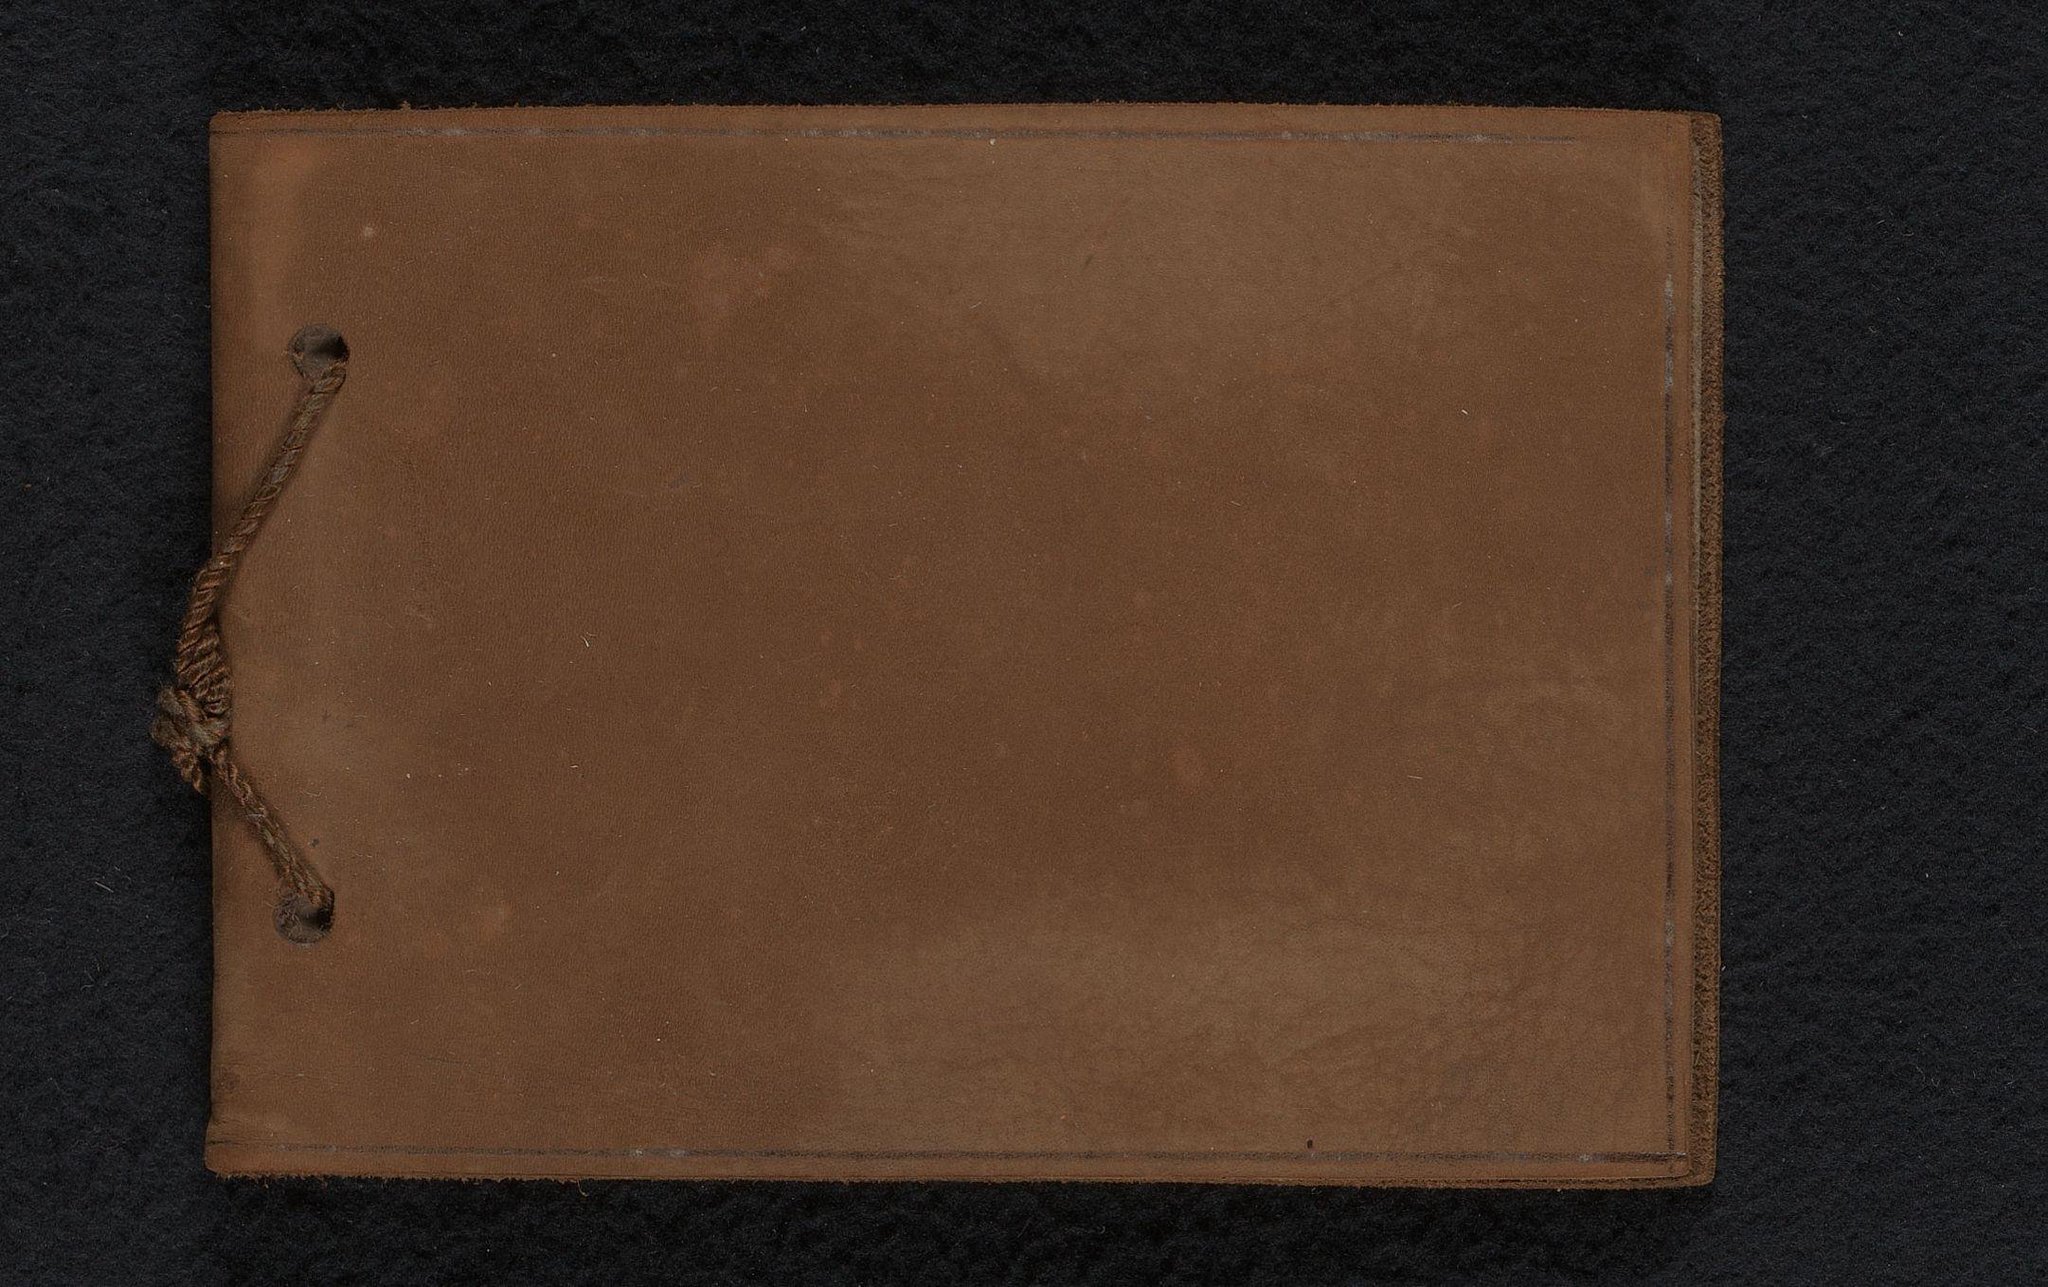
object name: photograph album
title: Fotoalbum met vijftien foto's van een onbekende familie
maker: Anonymous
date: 1900-1930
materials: paper, leather, textile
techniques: gelatin silver print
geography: netherlands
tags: historical persons not known by name - bb - woman, family group, especially parents with their child(ren)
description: Plakboek met vijftien foto's verdeeld over zestien pagina's, van een onbekende familie. Een foto zit los in het album. Mogelijk gaat het om de familie Langhout-Jonker, maar de gefotografeerde personen zijn onbekend.